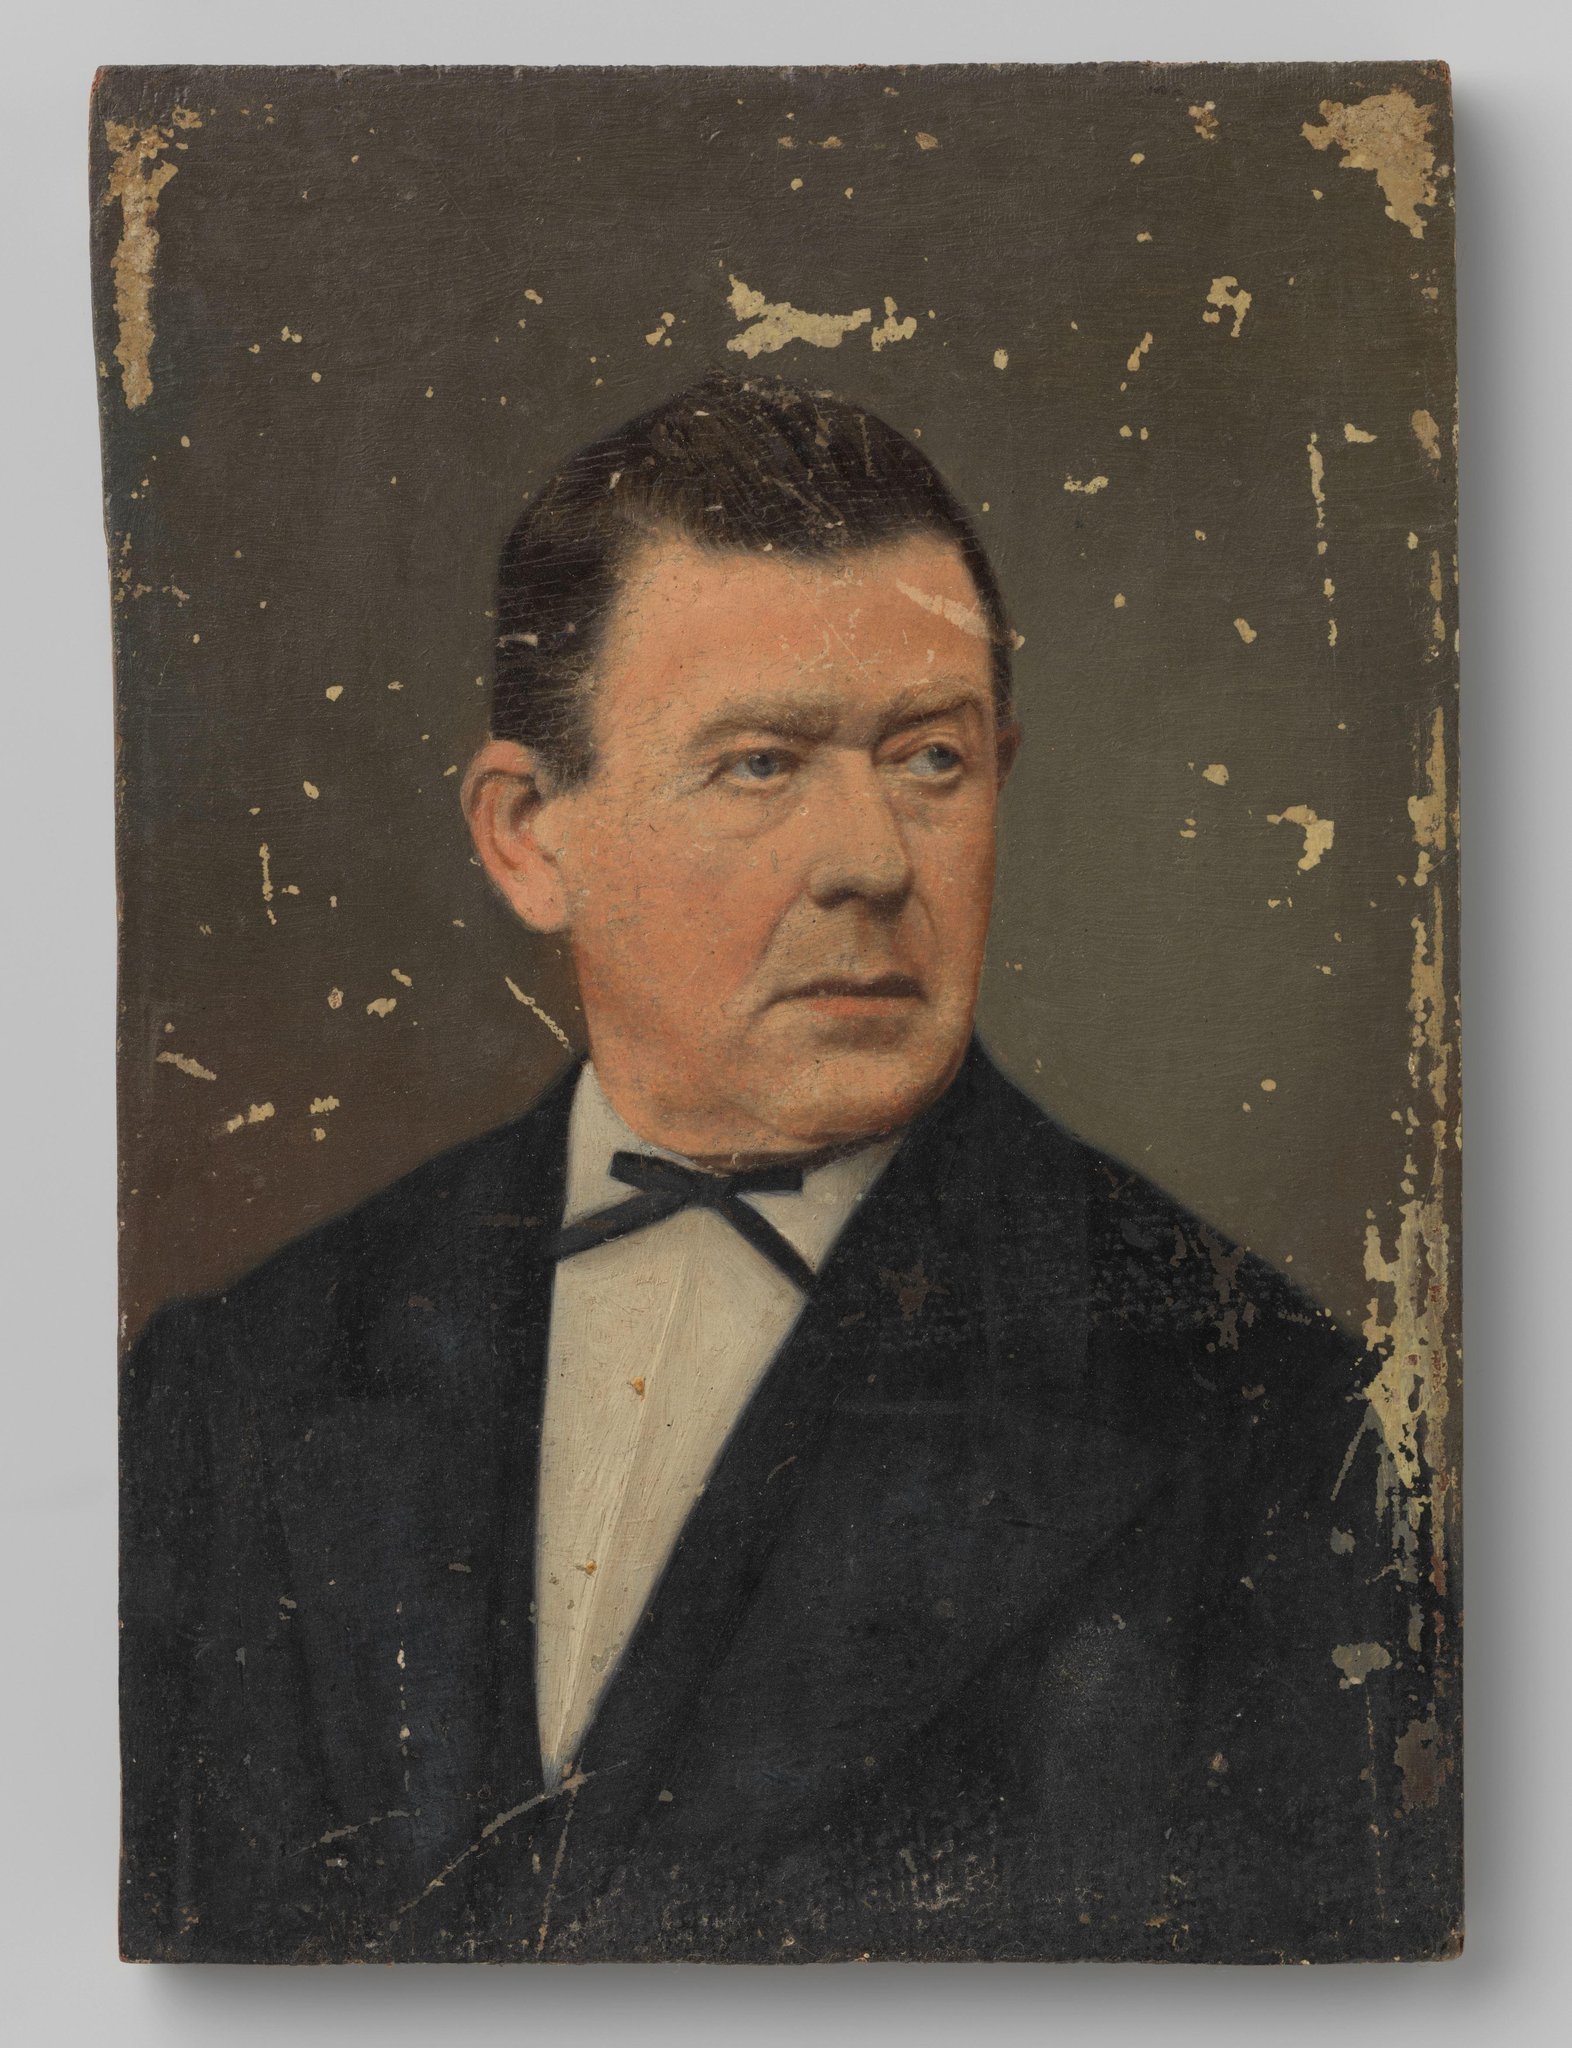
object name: photograph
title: Portret van een onbekende man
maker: Anonymous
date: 1880-1900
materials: paint, paper, wood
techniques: albumen print, hand coloring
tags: adult man, anonymous historical person portrayed